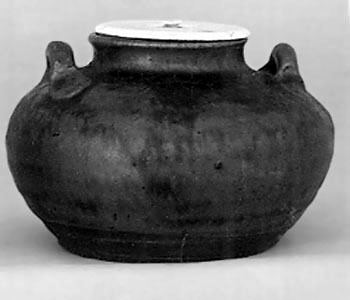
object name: tea jar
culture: japanese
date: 1601-1700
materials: clay, glaze